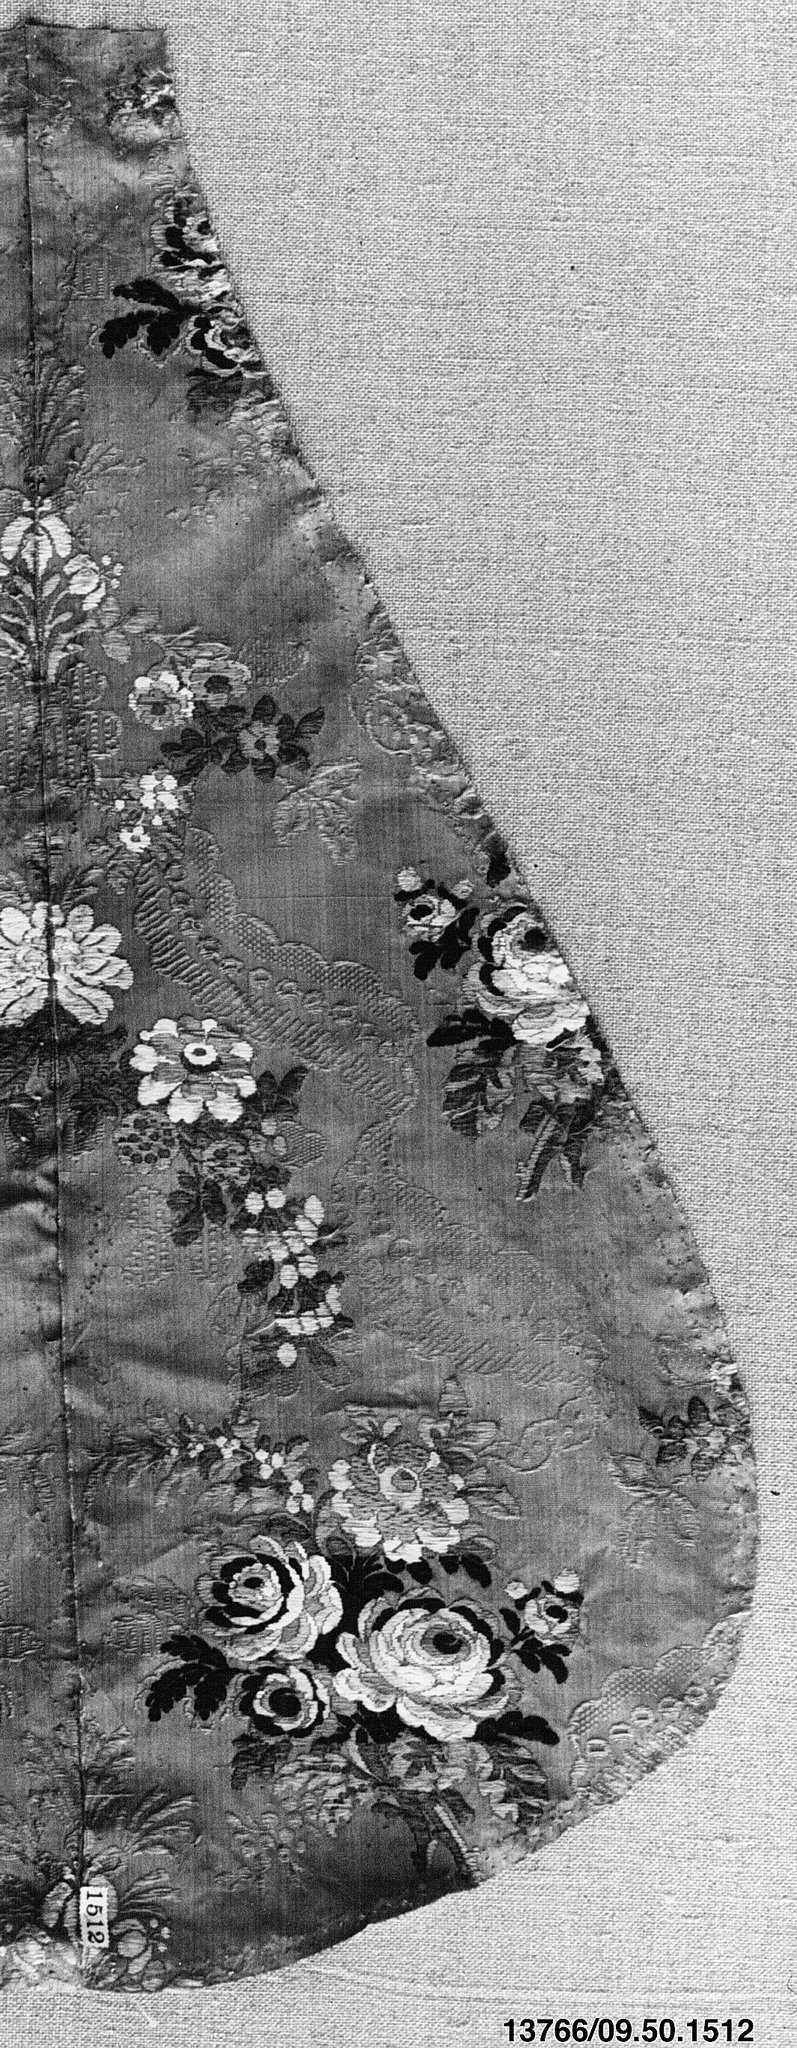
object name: piece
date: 1750-1760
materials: silk